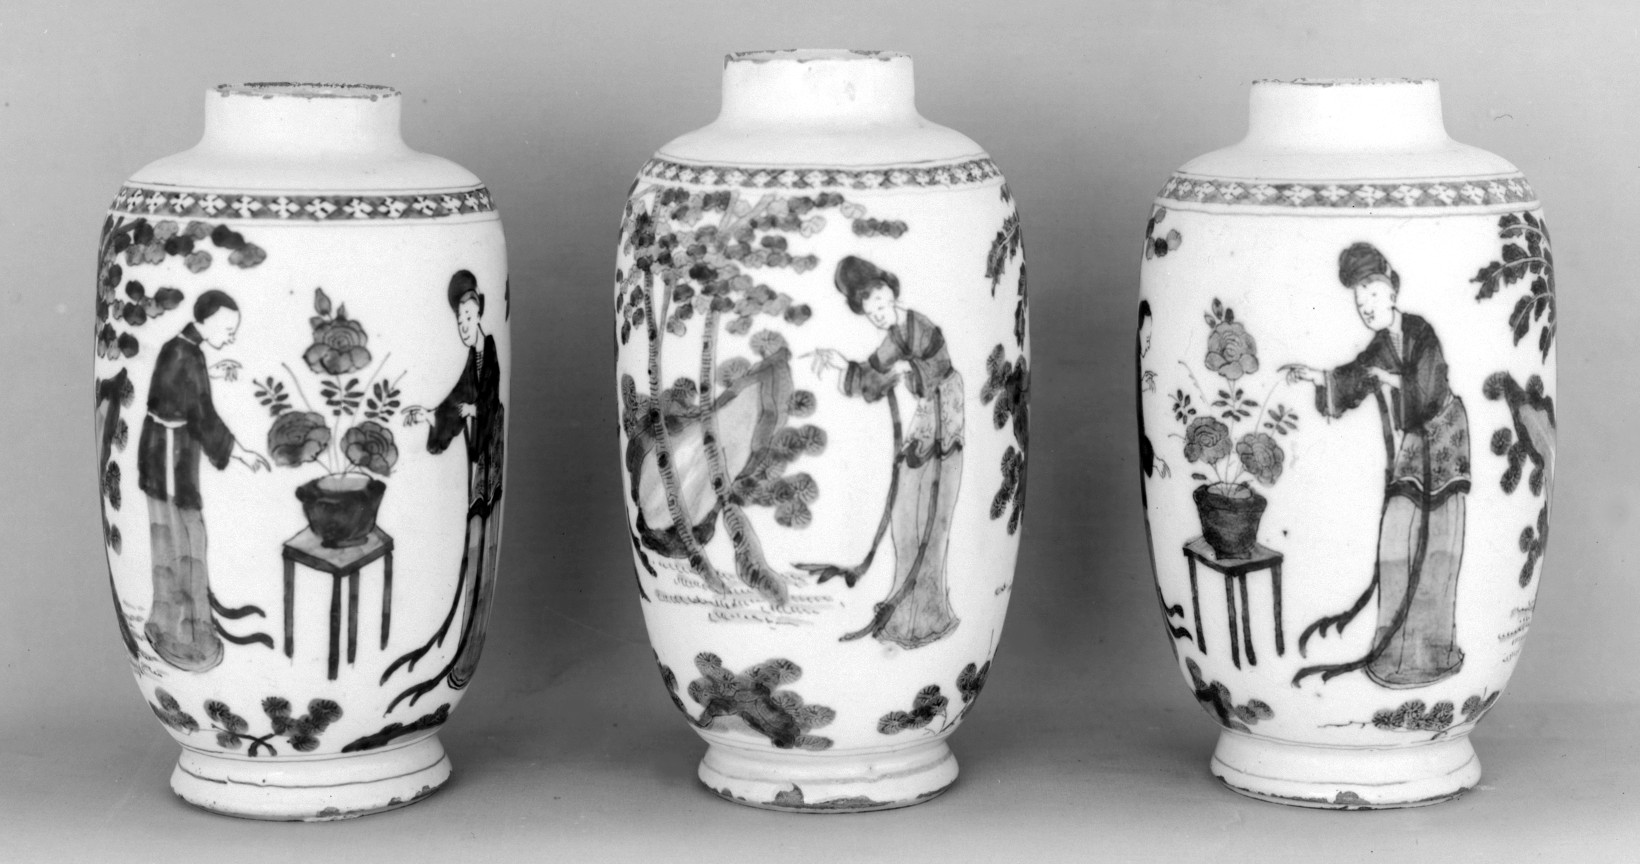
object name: vase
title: Vase (part of a garniture)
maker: de witte starre manufactory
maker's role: manufactory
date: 1723-1741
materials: earthenware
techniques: glazing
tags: human figures,flowers